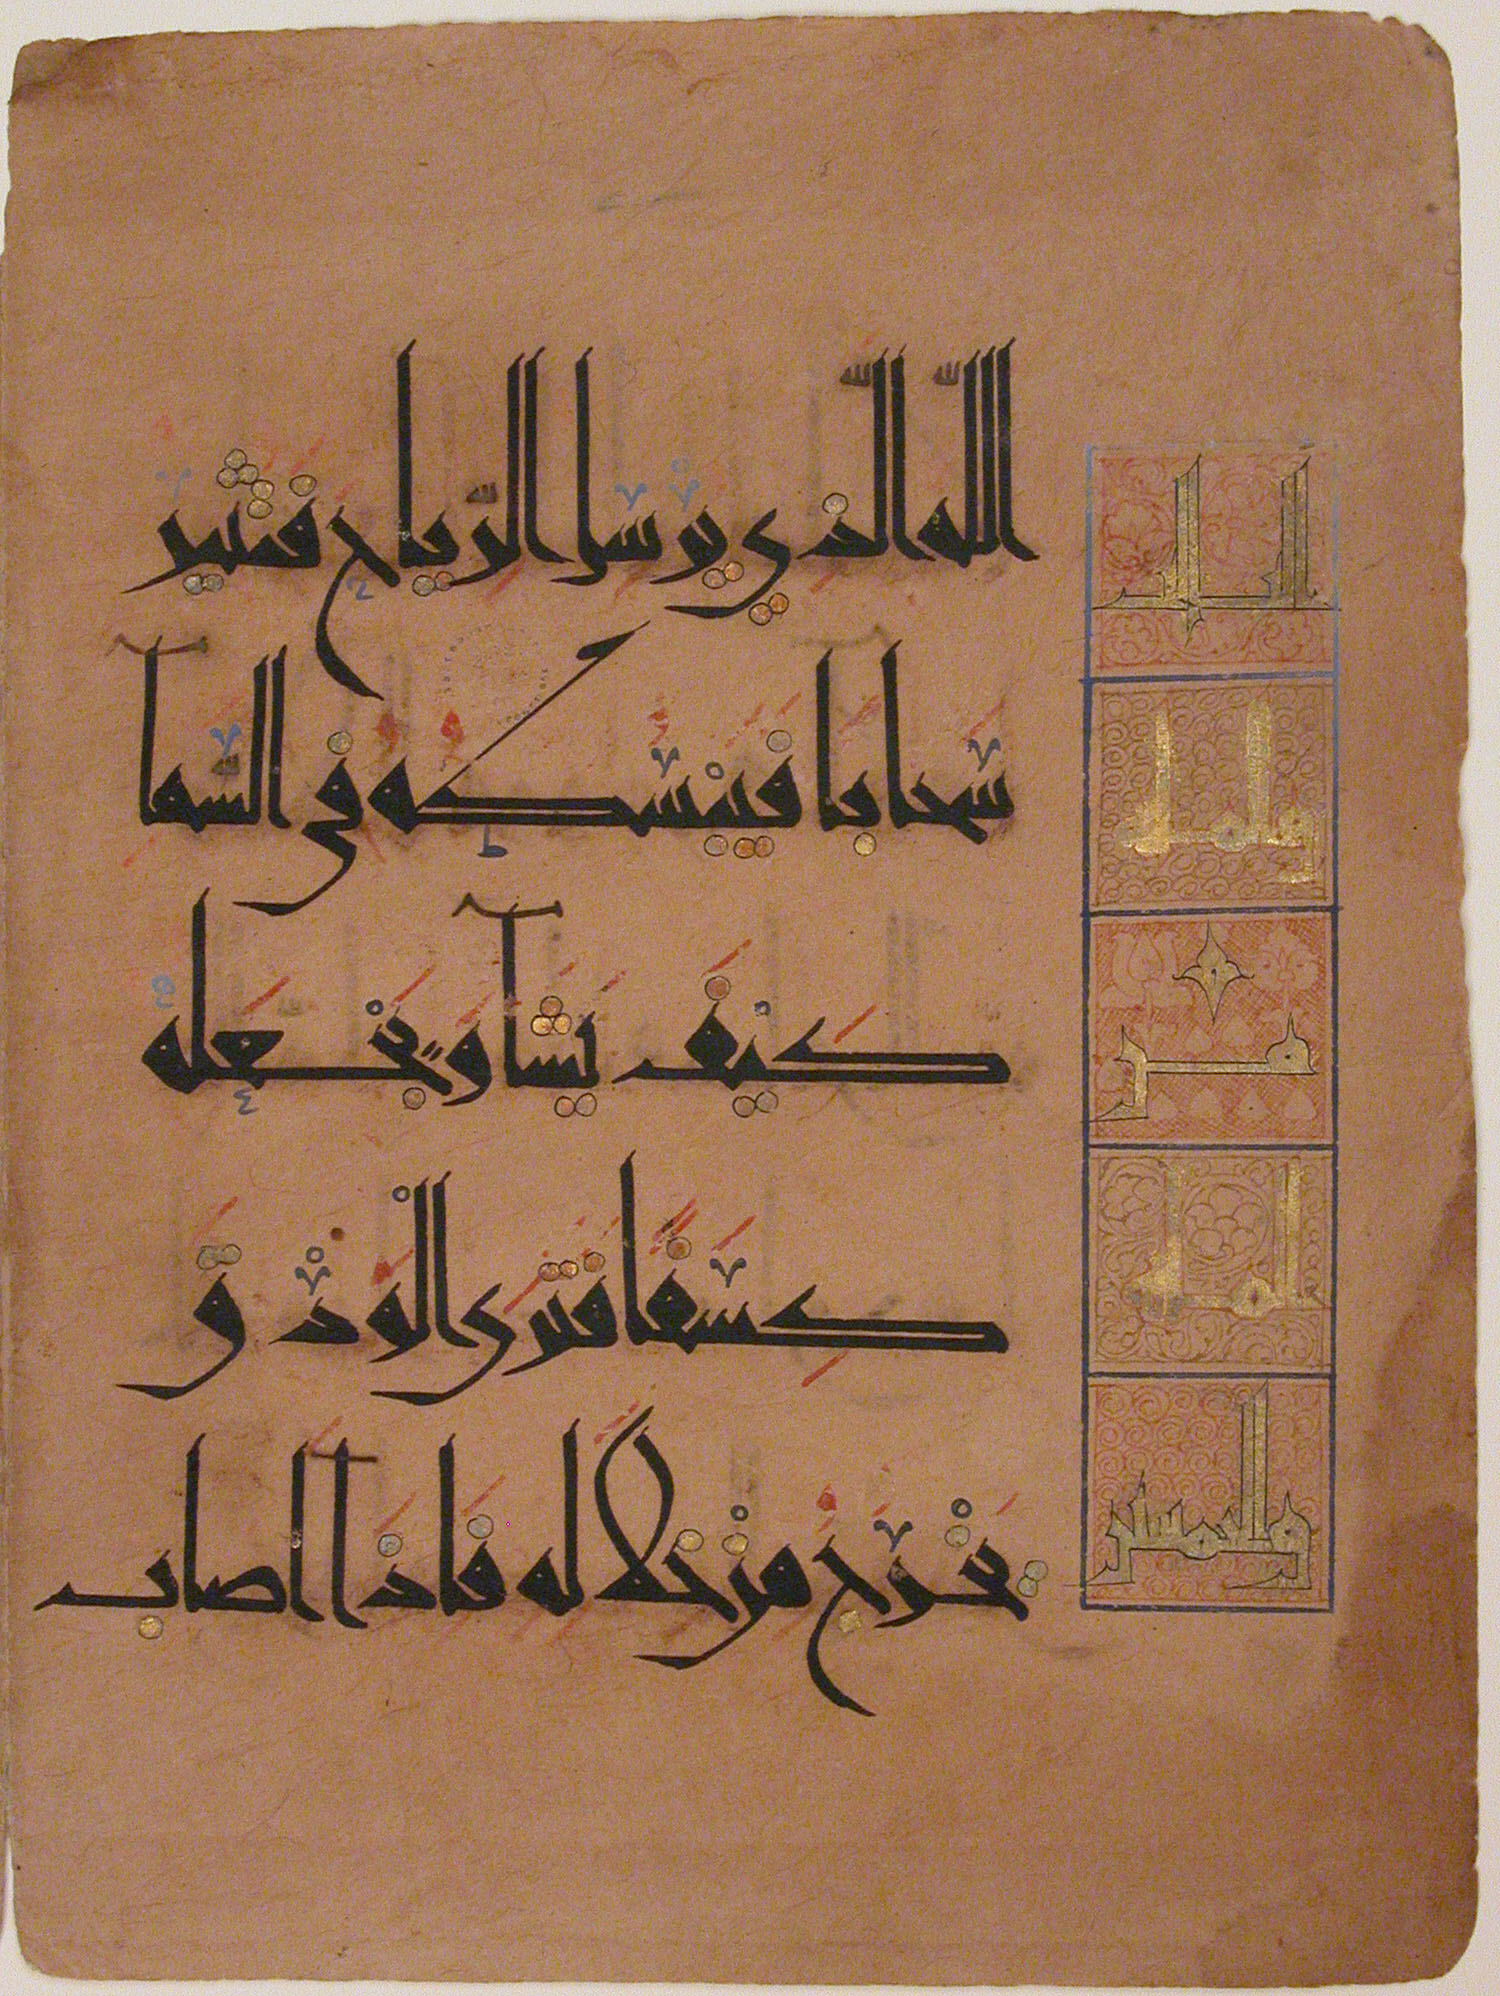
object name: folio from a non illustrated manuscript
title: Folio from a Qur'an Manuscript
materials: gold, ink, paper, watercolor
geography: afghanistan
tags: arabic,qur'an,calligraphy